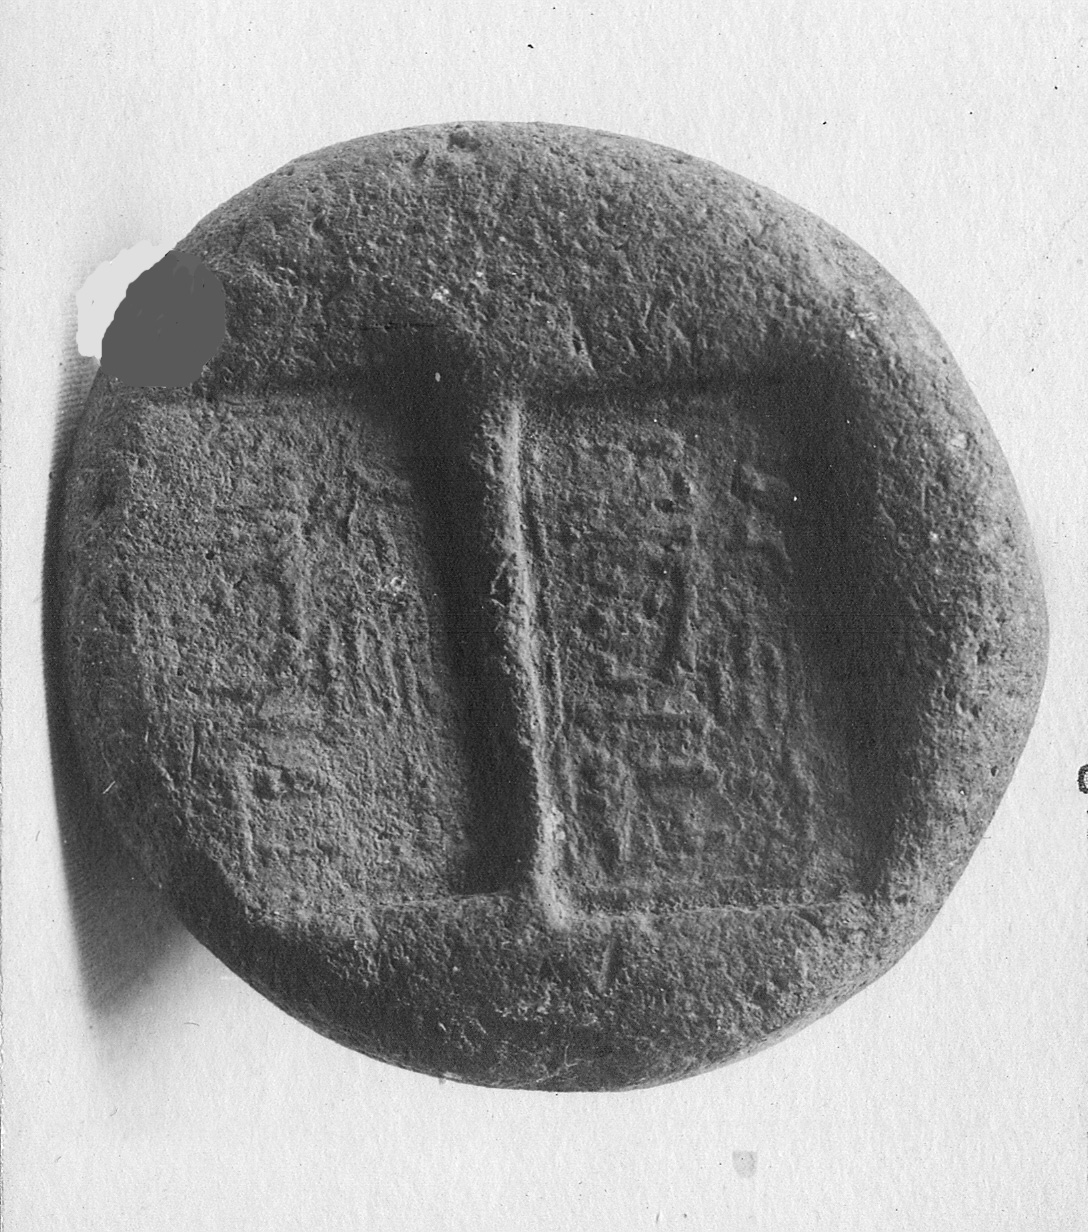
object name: cone, rectangular 2 impression, djehutimose, wab priest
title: Funerary Cone of Djehutymose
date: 1550-1295 BCE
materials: pottery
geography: egypt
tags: hieroglyphs